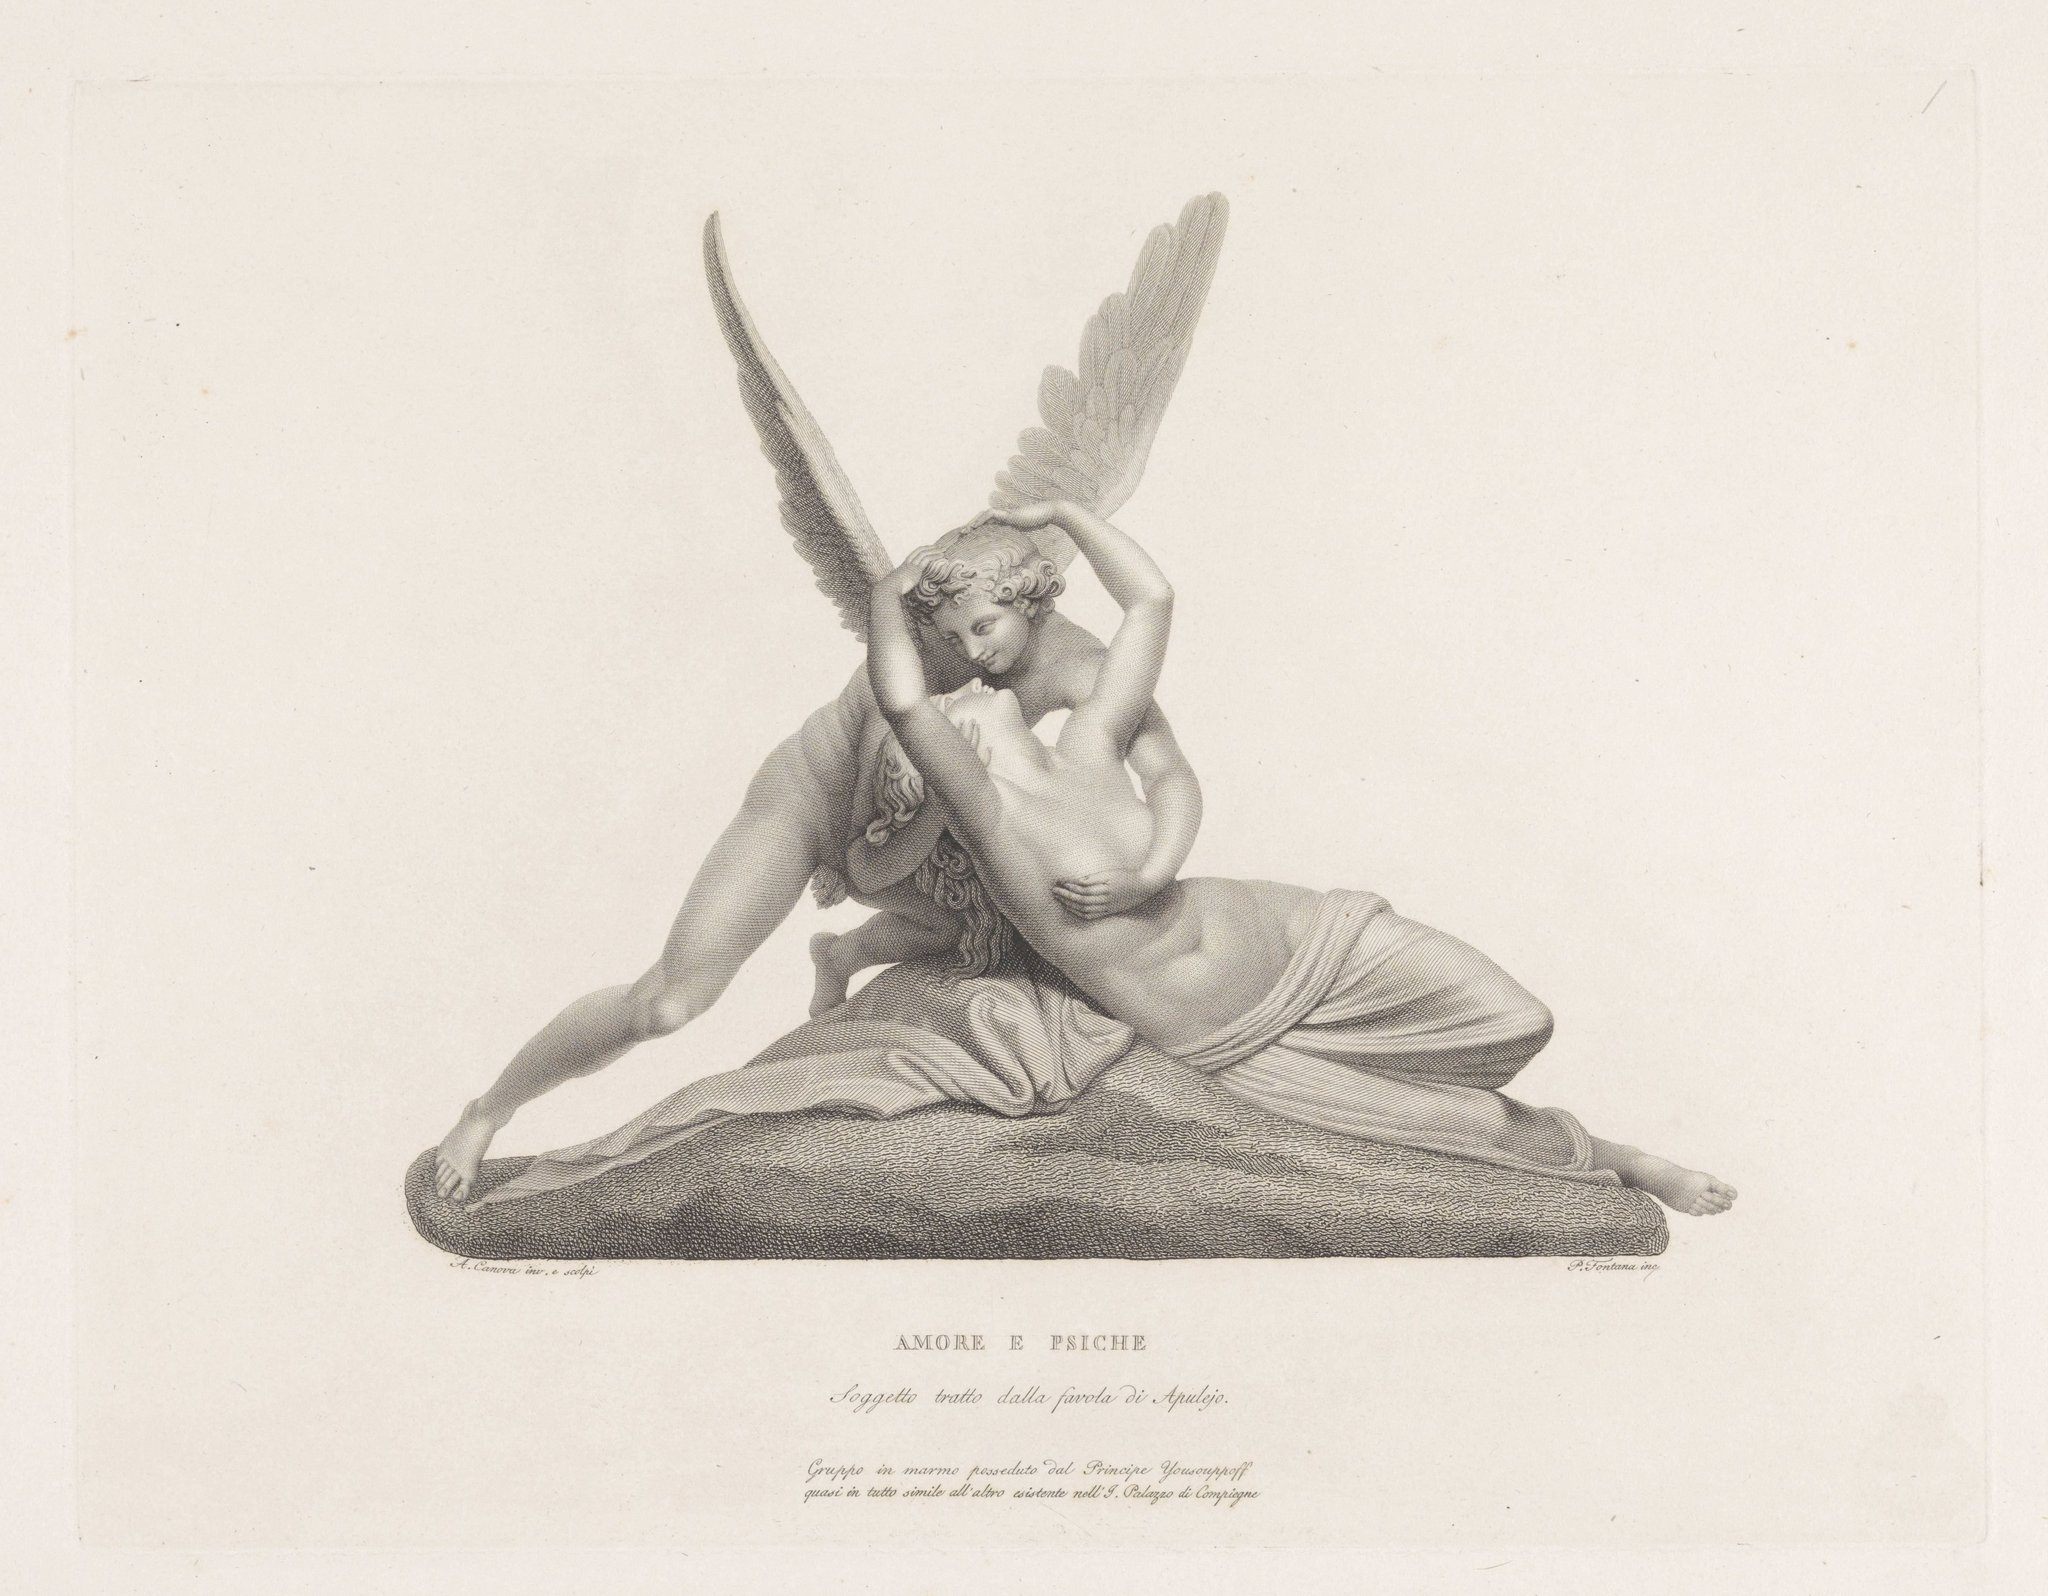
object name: print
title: Amor en Psyche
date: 1772-1837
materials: paper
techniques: engraving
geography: italy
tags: piece of sculpture, reproduction of a piece of sculpture, cupid and psyche as lovers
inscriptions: collector's mark: Lugt 12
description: Het originele sculptuur door Canova wordt bewaard in het Musée du Louvre te Parijs.